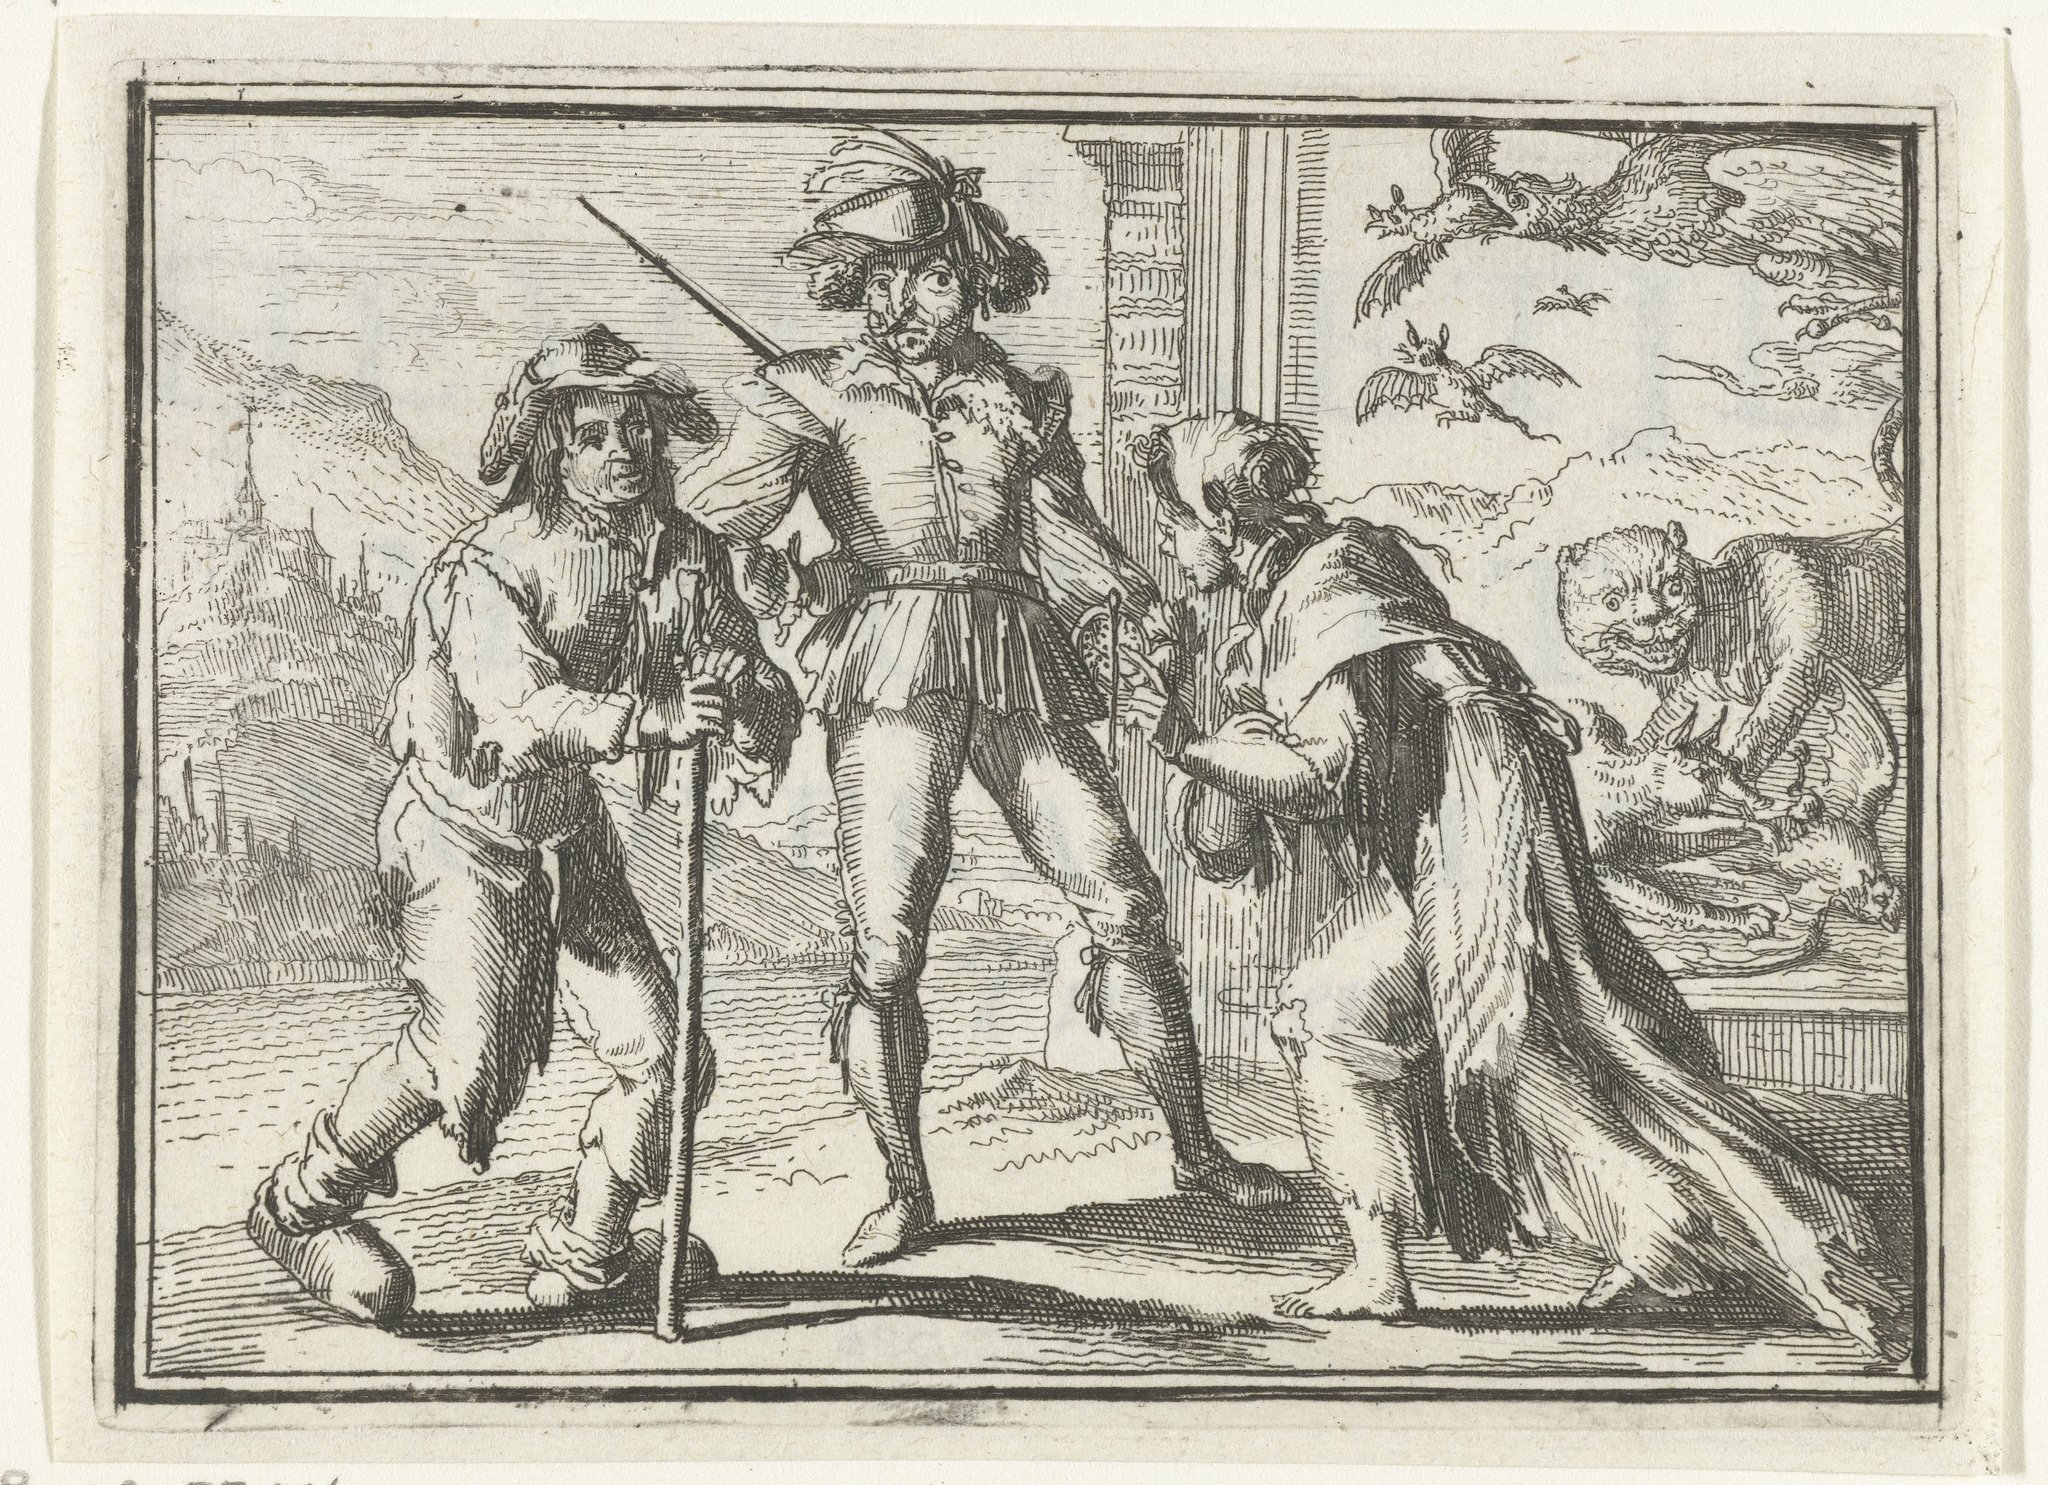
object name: print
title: Het Heydinnetje, de Miquelet, en Mooyfraaykiek, In de Pirenëen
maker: romeyn de hooghe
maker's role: draughtsman, goldsmith, painter, print maker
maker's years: 1645-1708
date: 1702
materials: paper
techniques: engraving, etching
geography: netherlands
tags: wandering communities: romani or roma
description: Soldaat (Savoye) staande tussen een bedelaar en een heidinnetje (zigeunerin), beiden in lompen. Titel staat op apart tekstblad